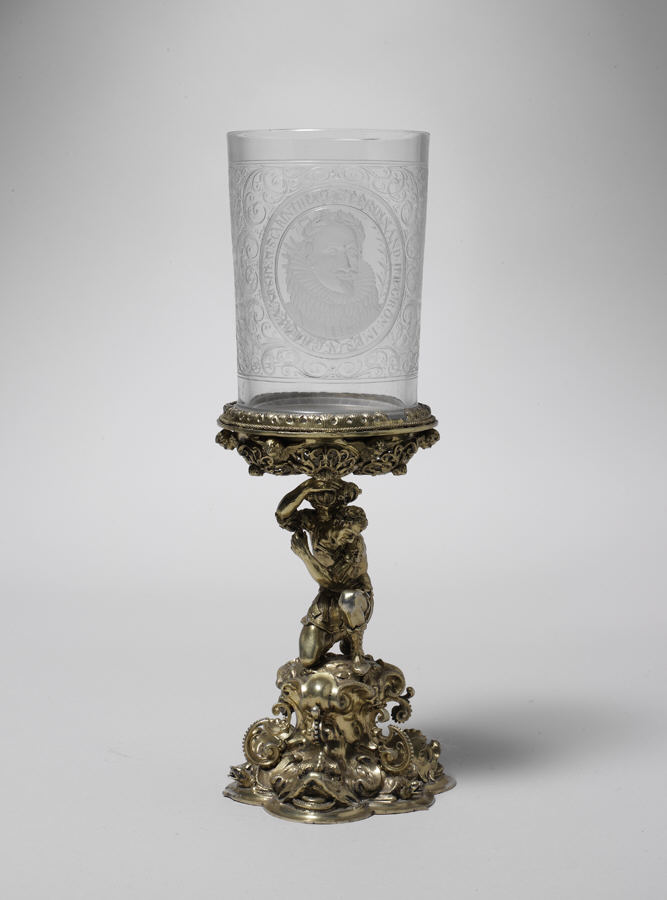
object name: standing cup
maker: wolff christoff ritter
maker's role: maker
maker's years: 1560-1660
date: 1601-1650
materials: glass, silver gilt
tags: men,portraits,coat of arms